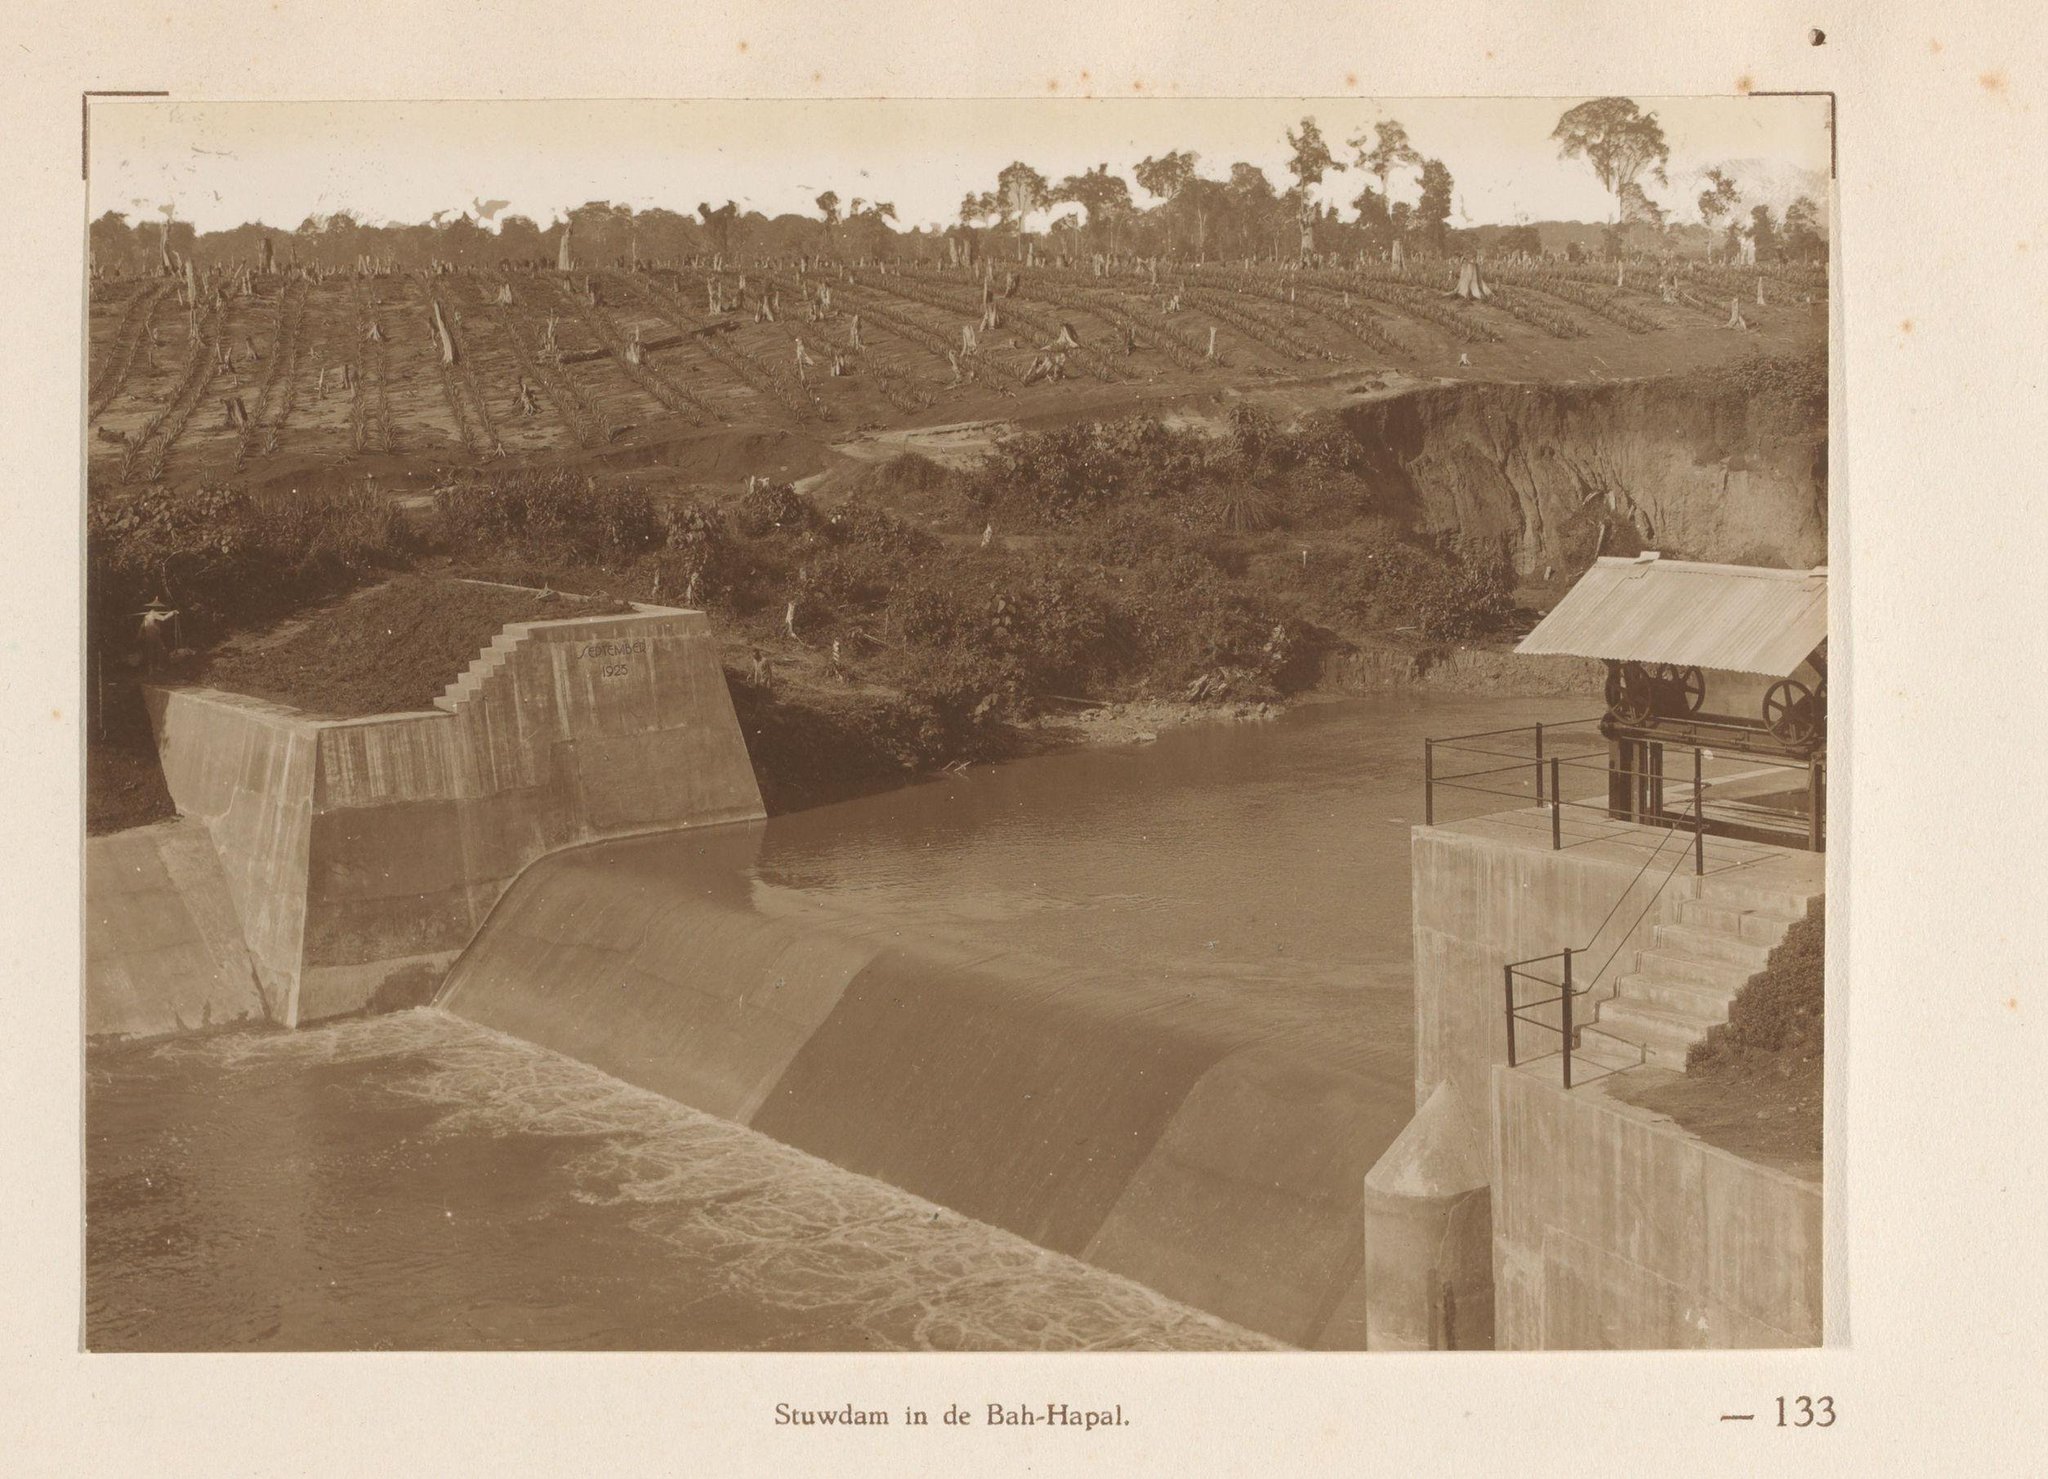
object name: album leaf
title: Pagina 133 van fotoboek van de Algemeene Vereeniging van Rubberplanters ter Oostkust van Sumatra (A.V.R.O.S.)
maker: j.w. meyster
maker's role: fotograaf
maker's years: 1887-1945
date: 1924-1925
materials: paper, photographic support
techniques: printing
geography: sumatra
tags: (non-fruit) products of plants or trees: rubber, barrage, sumatra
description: Boekpagina met een foto van een stuwdam in Bah-Hapal. Onderdeel van een fotoboek van de Algemeene Vereeniging van Rubberplanters ter Oostkust van Sumatra (A.V.R.O.S.).